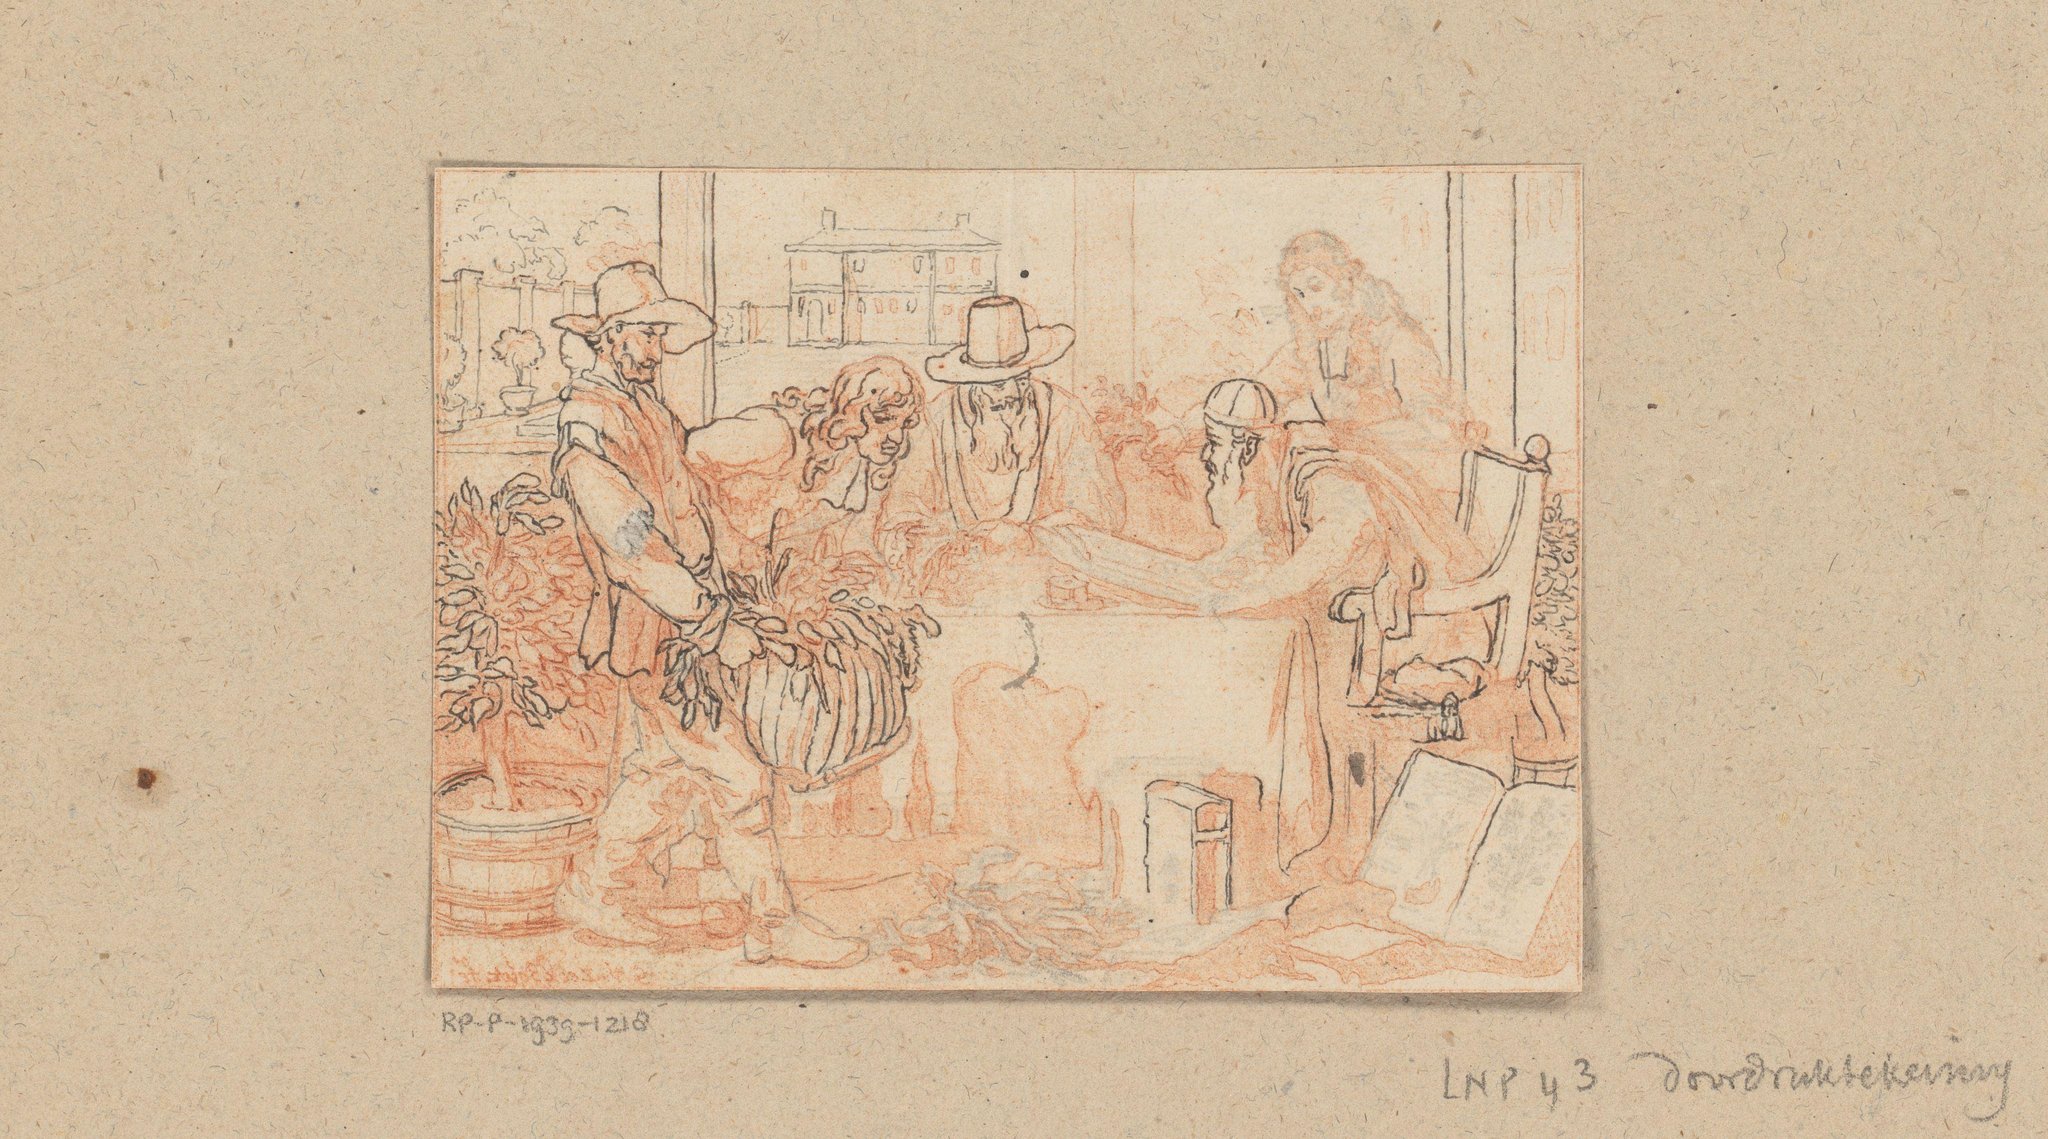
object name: drawing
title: Botanicus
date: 1780-1787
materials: chalk, ink, paper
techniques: brush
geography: amsterdam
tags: enjoying nature ~ plants, herbs and flowers, botany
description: Enkele mannen bestuderen planten aan een tafel. De oude zittende man schrijft in een boek. Links draagt een man een mand met planten. Door de ramen zicht op een tuin en een landhuis. De doordruktekening ligt los in een album, zie blad 43.